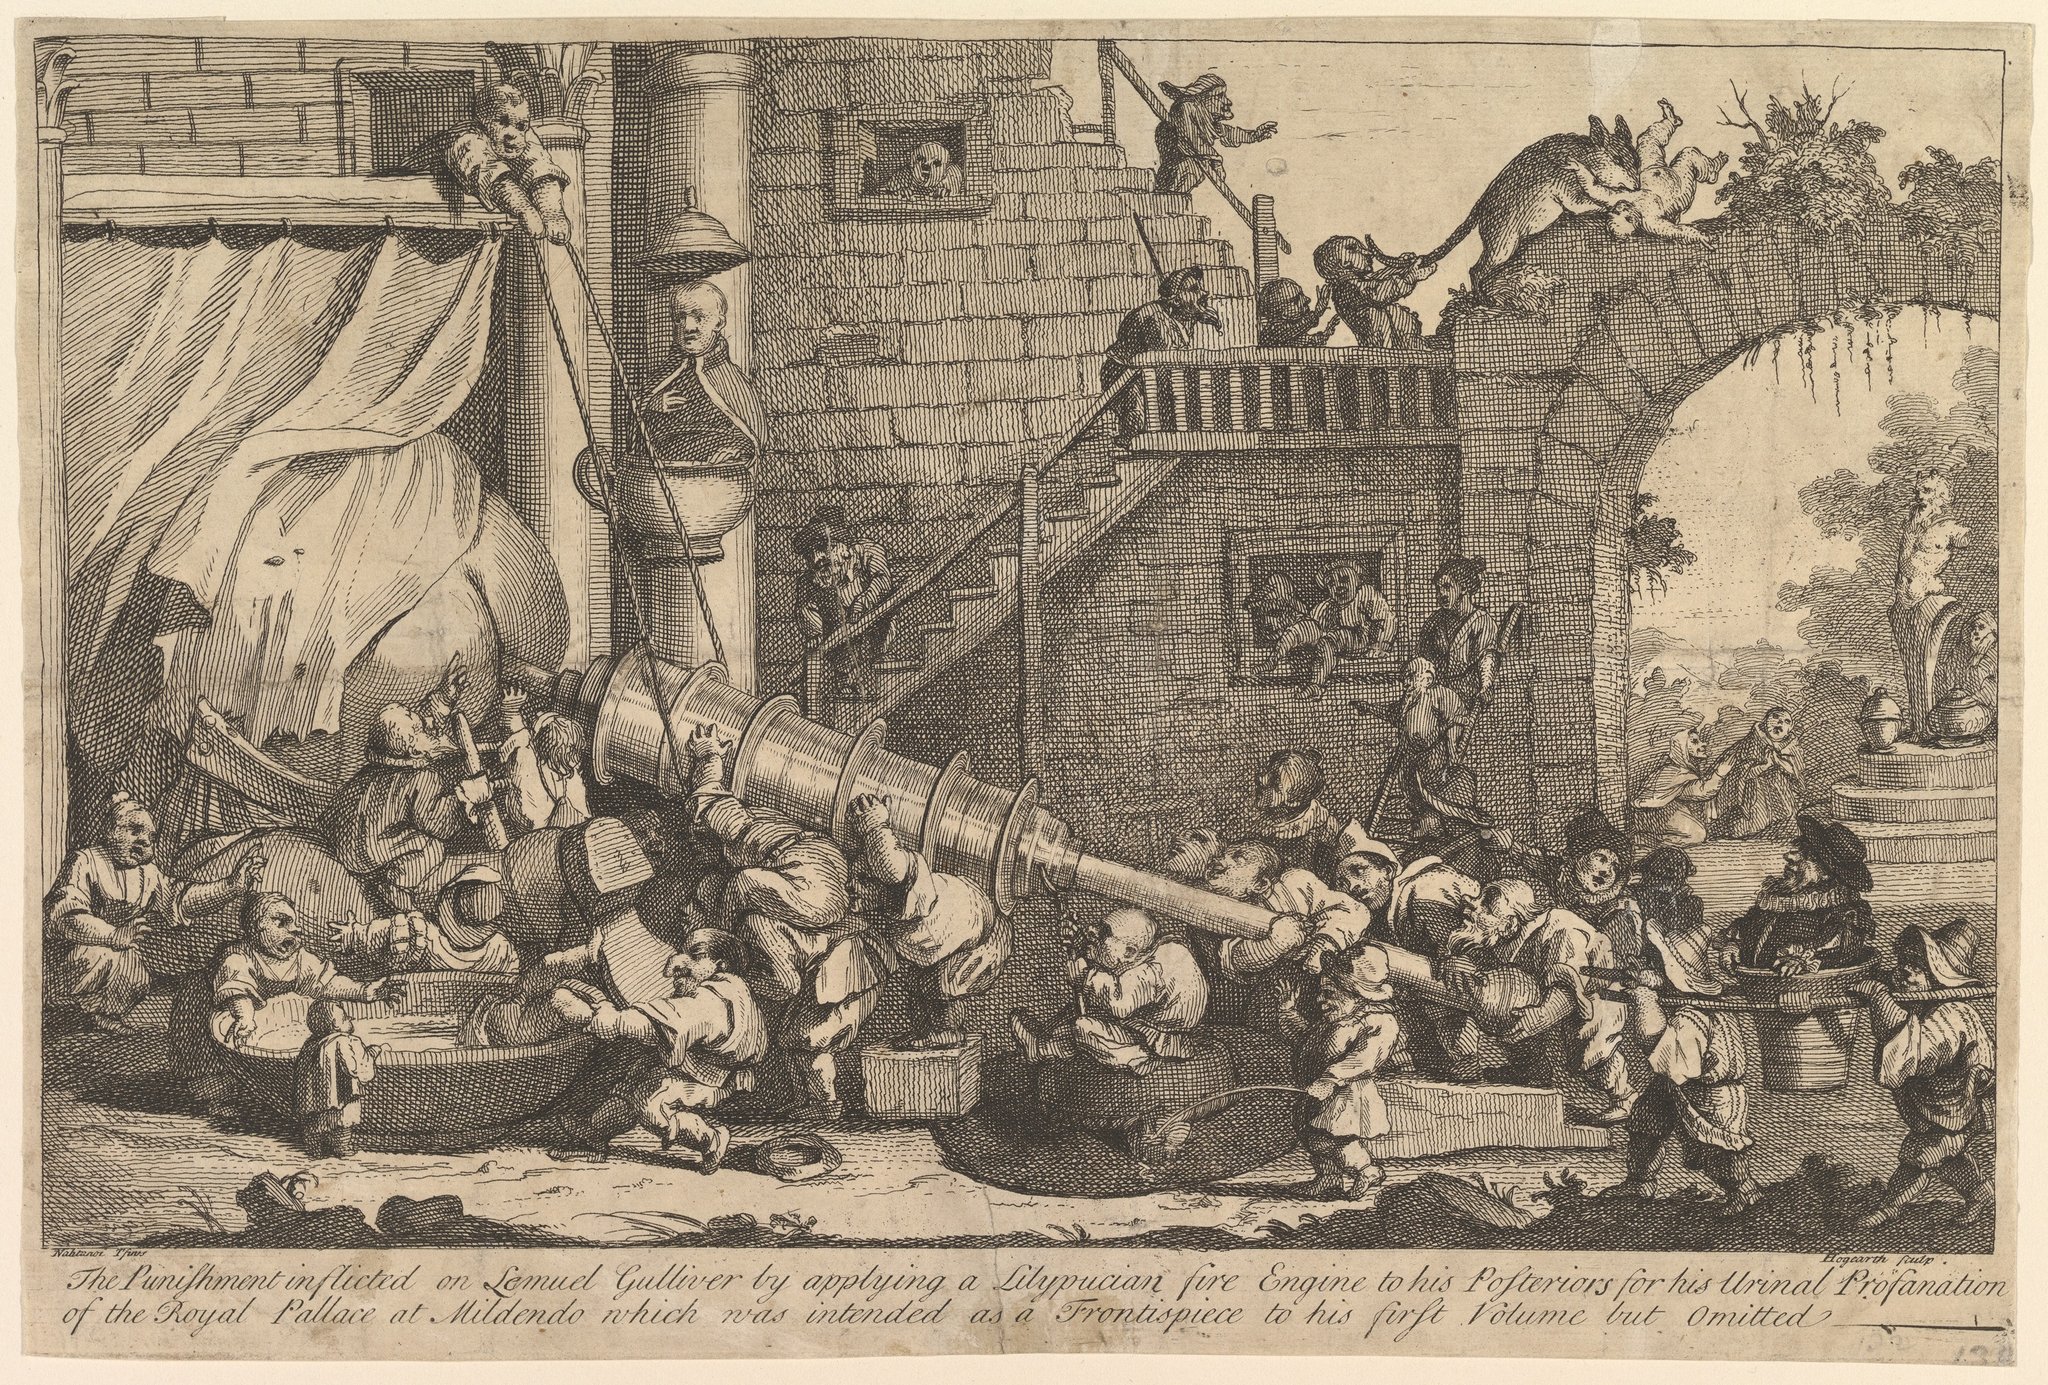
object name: print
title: The Punishment Inflicted on Lemuel Gulliver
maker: william hogarth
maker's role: artist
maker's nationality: british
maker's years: 1697-1764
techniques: engraving, etching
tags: satire,men